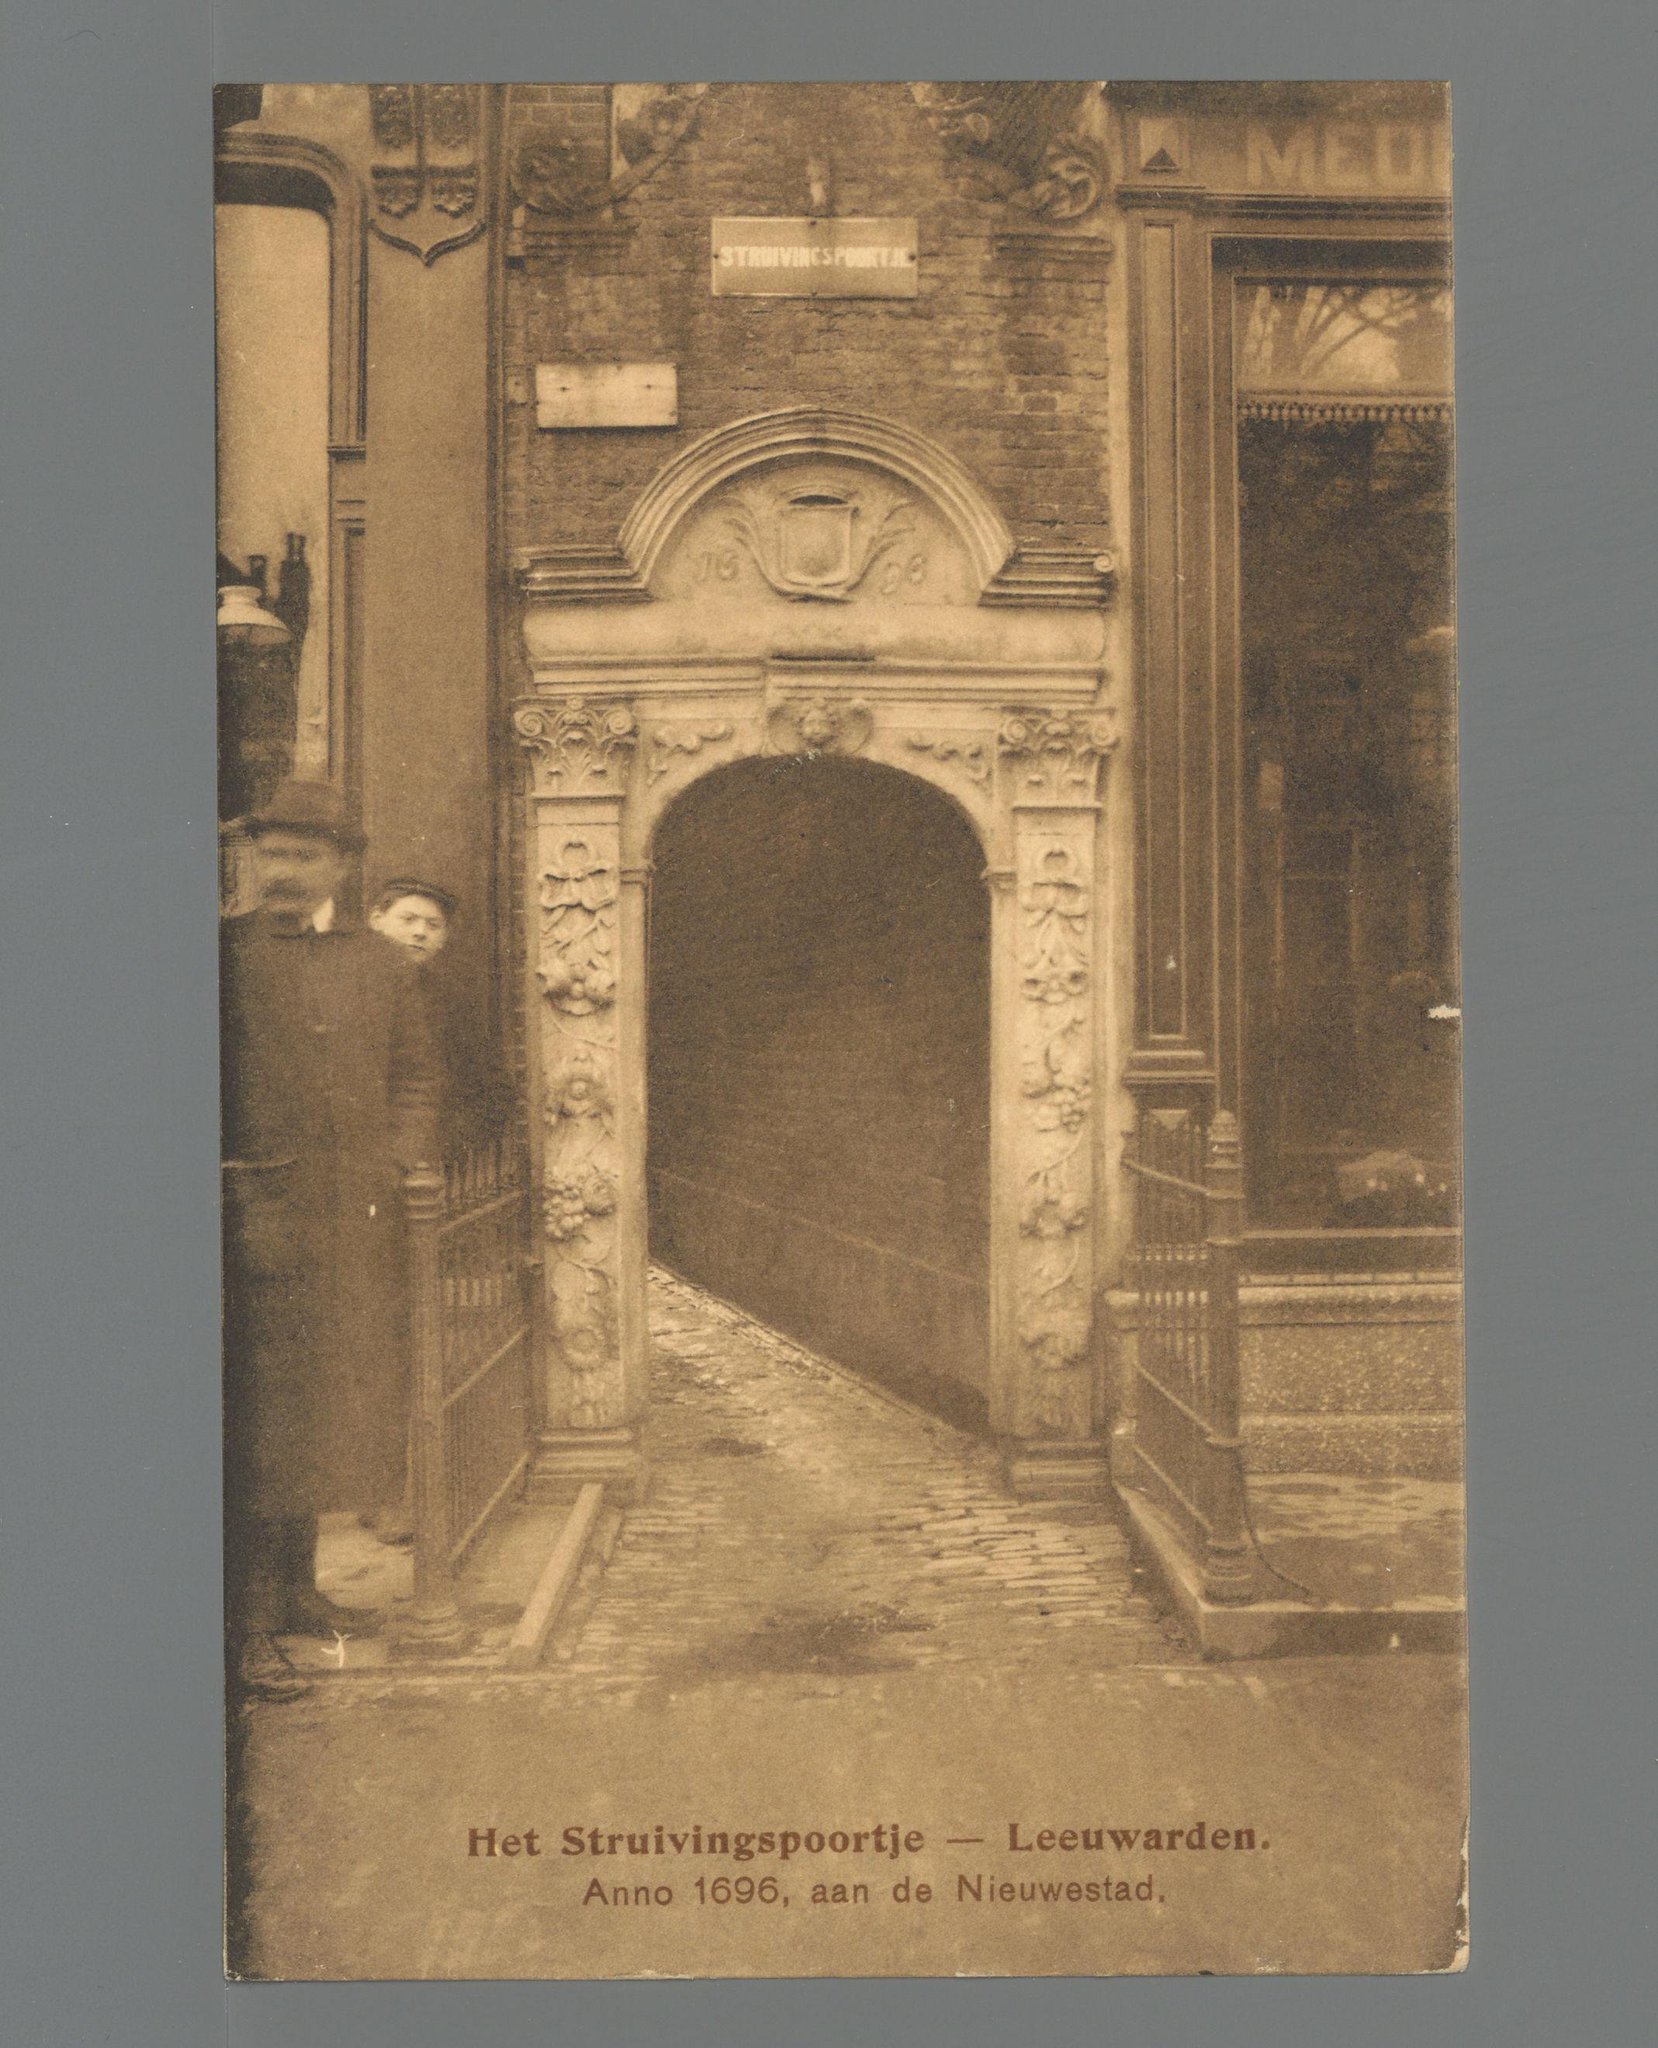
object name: photomechanical print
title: Het Struivingspoortje - Leeuwarden. Anno 1696, aan de Nieuwestad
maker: Anonymous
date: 1905-1930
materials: cardboard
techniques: photograph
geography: leeuwarden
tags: gate, entrance